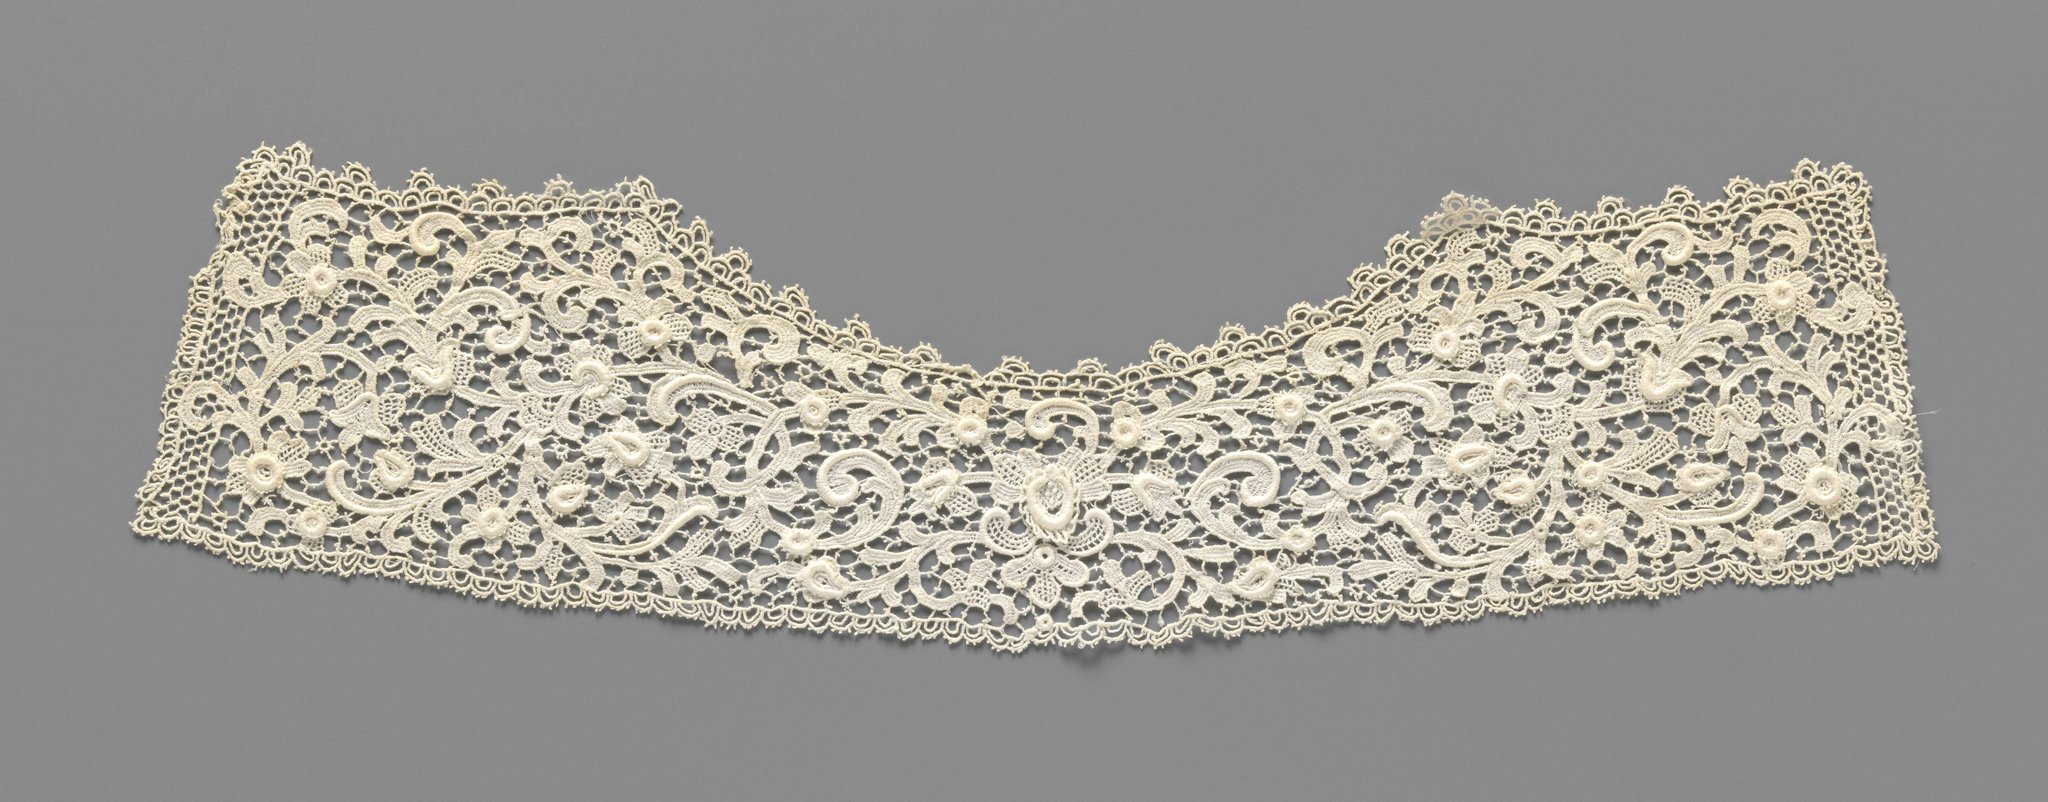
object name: womenswear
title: Kraag van machinale kant met omkrullende bloemranken en c-voluten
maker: Anonymous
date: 1900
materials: cotton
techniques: lace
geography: sankt gallen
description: Kraag van machinale kant: machinale Venetiaanse reliëfkant (etskant). Lichtgebogen rechthoekig model met flauwe ronde neklijn. Het symmetrische patroon bestaat uit omkrullende bloemranken en c-voluten. Reliëf rond bloemharten en sommige bladerranden en c-voluten. De motieven zijn met elkaar verbonden door een machinale spijlengrond met picots. De kraag is rondom afgewerkt met een boogjesrand met picots.